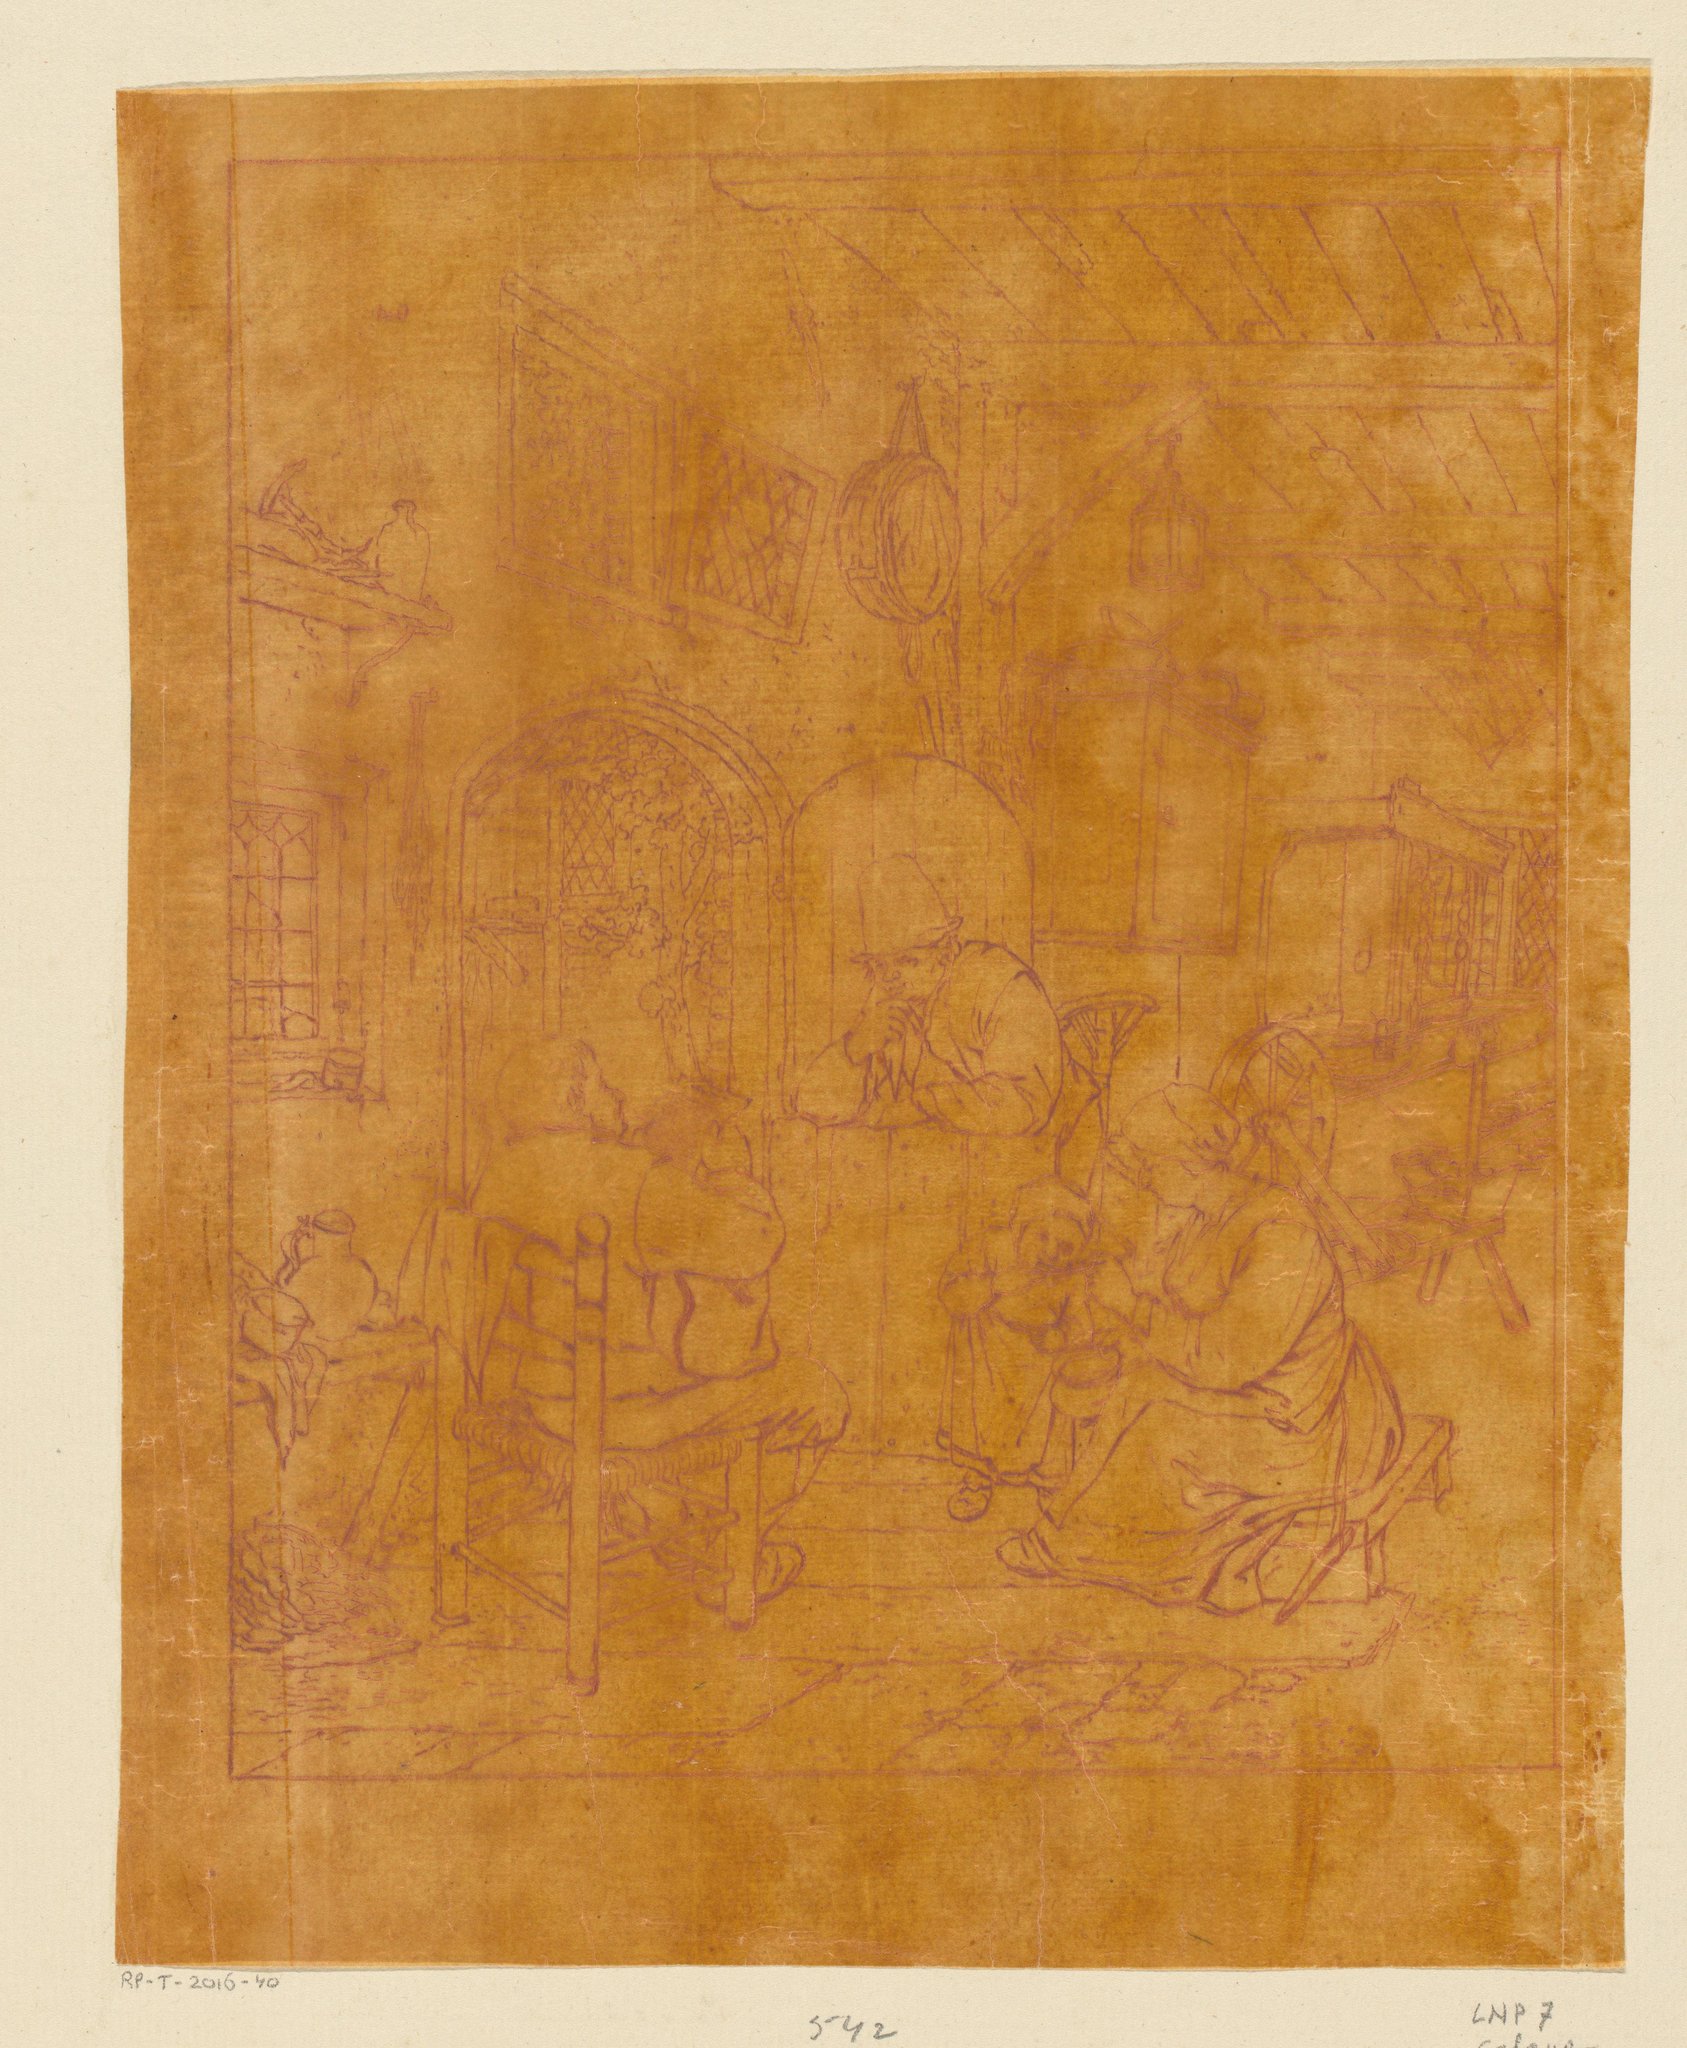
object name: tracing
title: Krantlezer in interieur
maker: cornelis ploos van amstel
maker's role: draughtsman, print maker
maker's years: 1726-1798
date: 1766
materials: chalk, paper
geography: amsterdam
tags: interior of the house, mother and baby or young child, newspaper, news-sheet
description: In een interieur leest een man de krant en geeft een vrouw een kind te eten. Op de geopende onderdeur leunt een man. De calque ligt los in een album, zie blad 7.